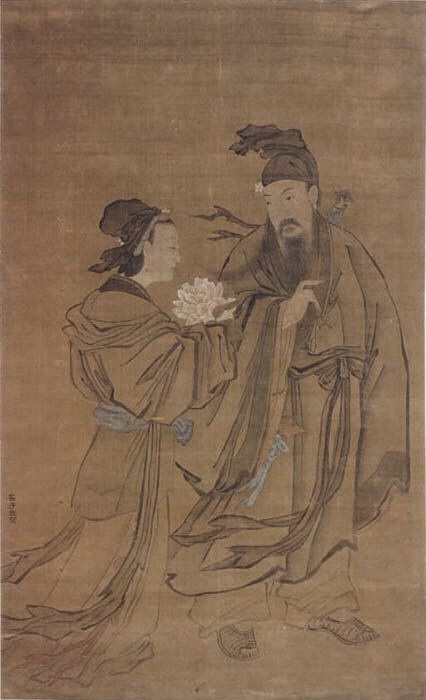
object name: hanging scroll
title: Lȕ Dongbin and the Spirit of the Peony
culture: chinese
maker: unidentified artist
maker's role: artist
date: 1368-1911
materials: ink, silk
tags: men,women,peonies